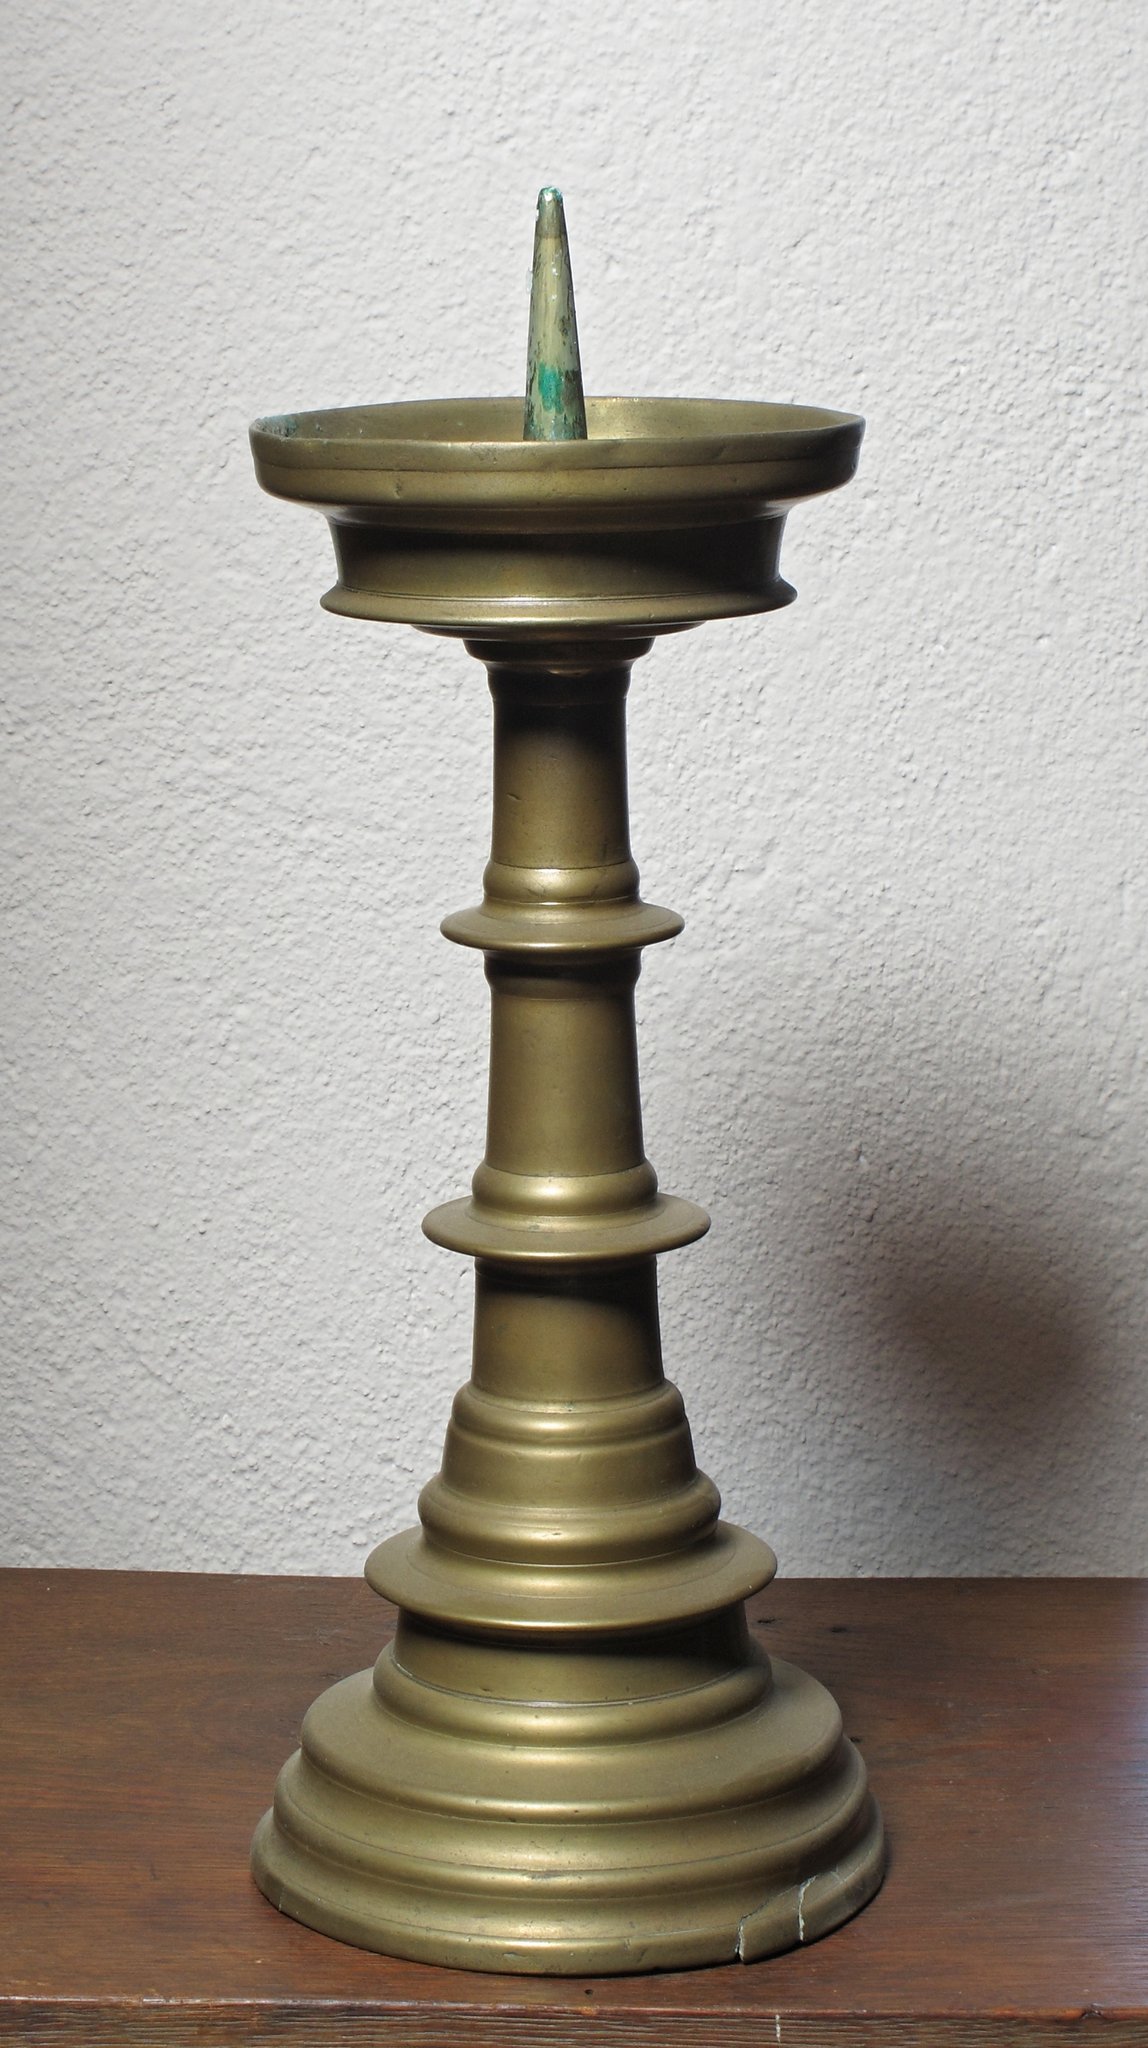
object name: candlestick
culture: german or south netherlandish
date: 1467-1500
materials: copper alloy